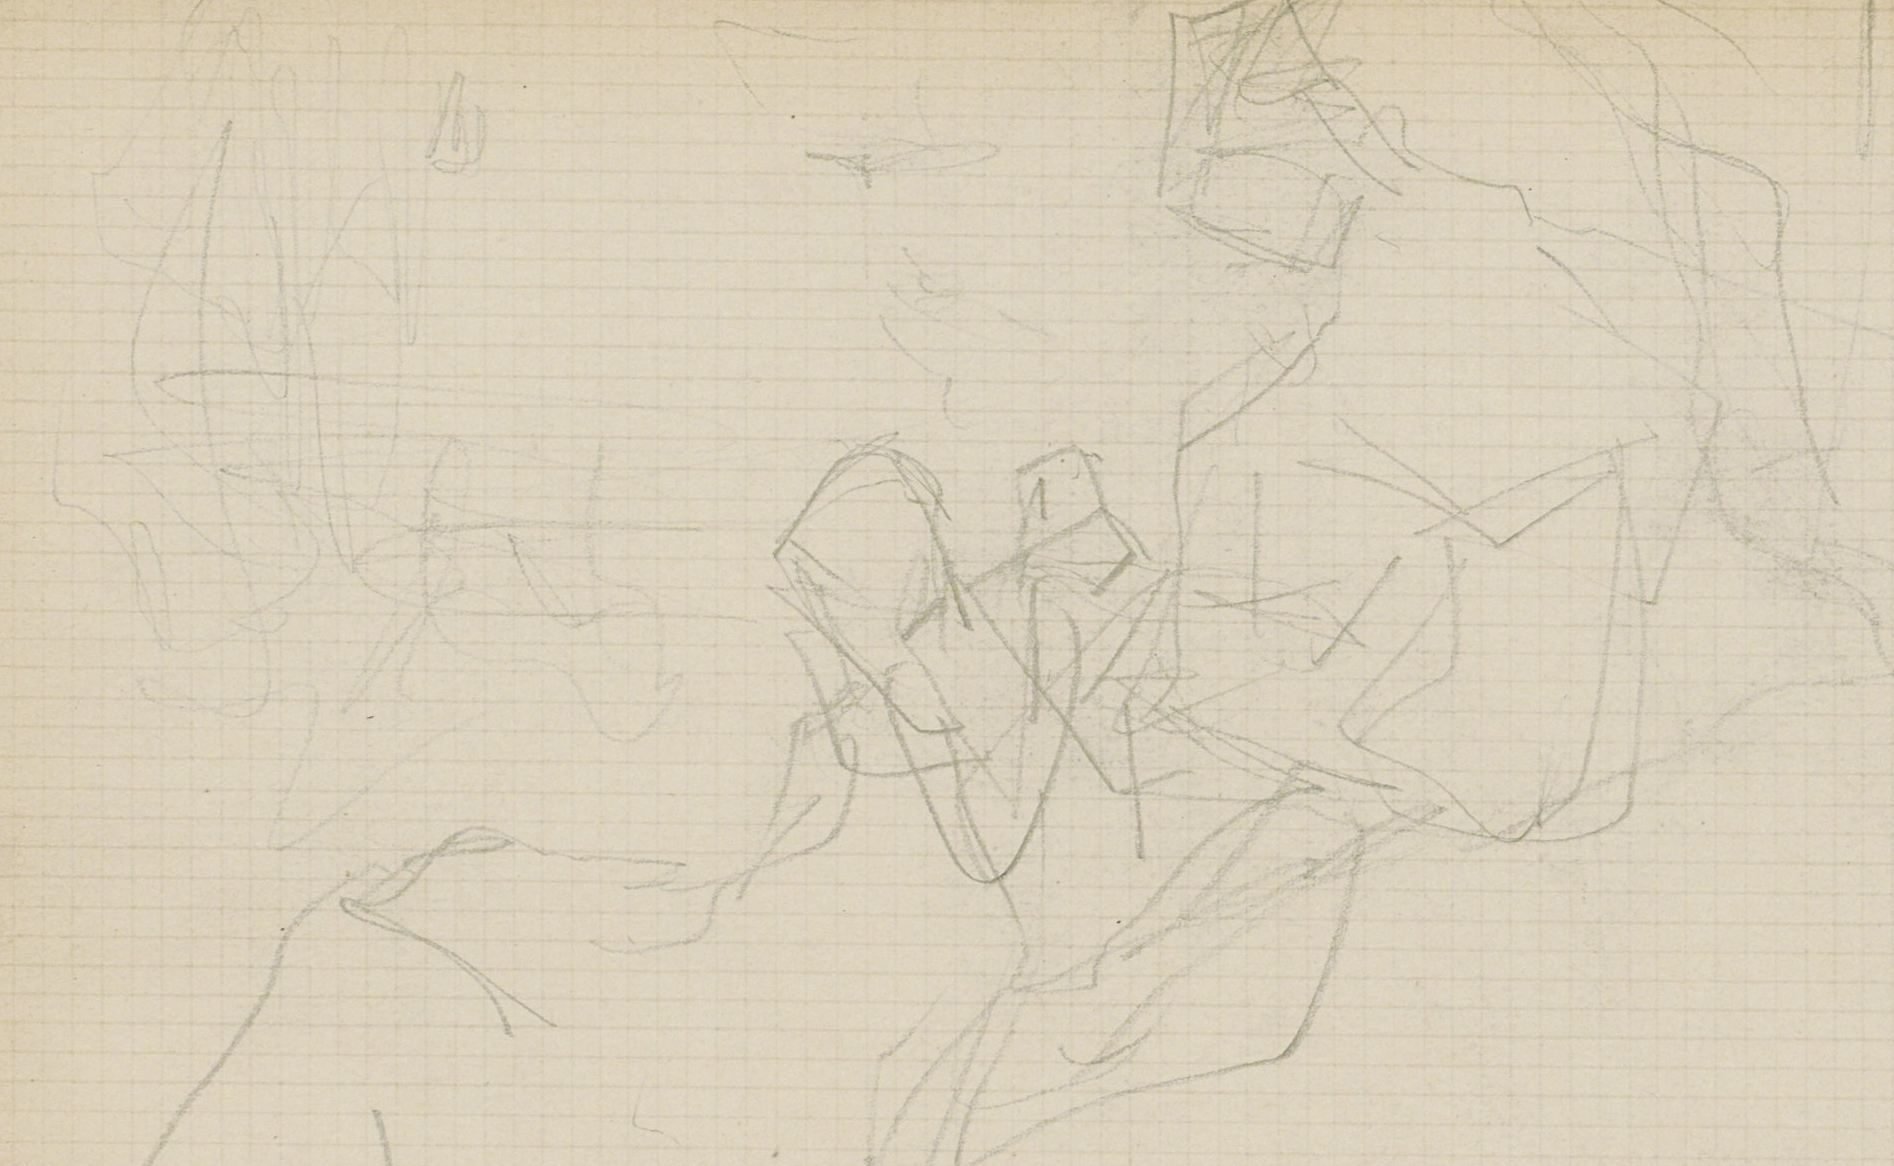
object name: sketchbook leaf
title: Twee figuren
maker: matthijs maris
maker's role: draughtsman, painter, print maker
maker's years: 1839-1917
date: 1849-1917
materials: pencil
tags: anatomy (non-medical)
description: Blad 25 verso uit een schetsboek met 35 bladen.